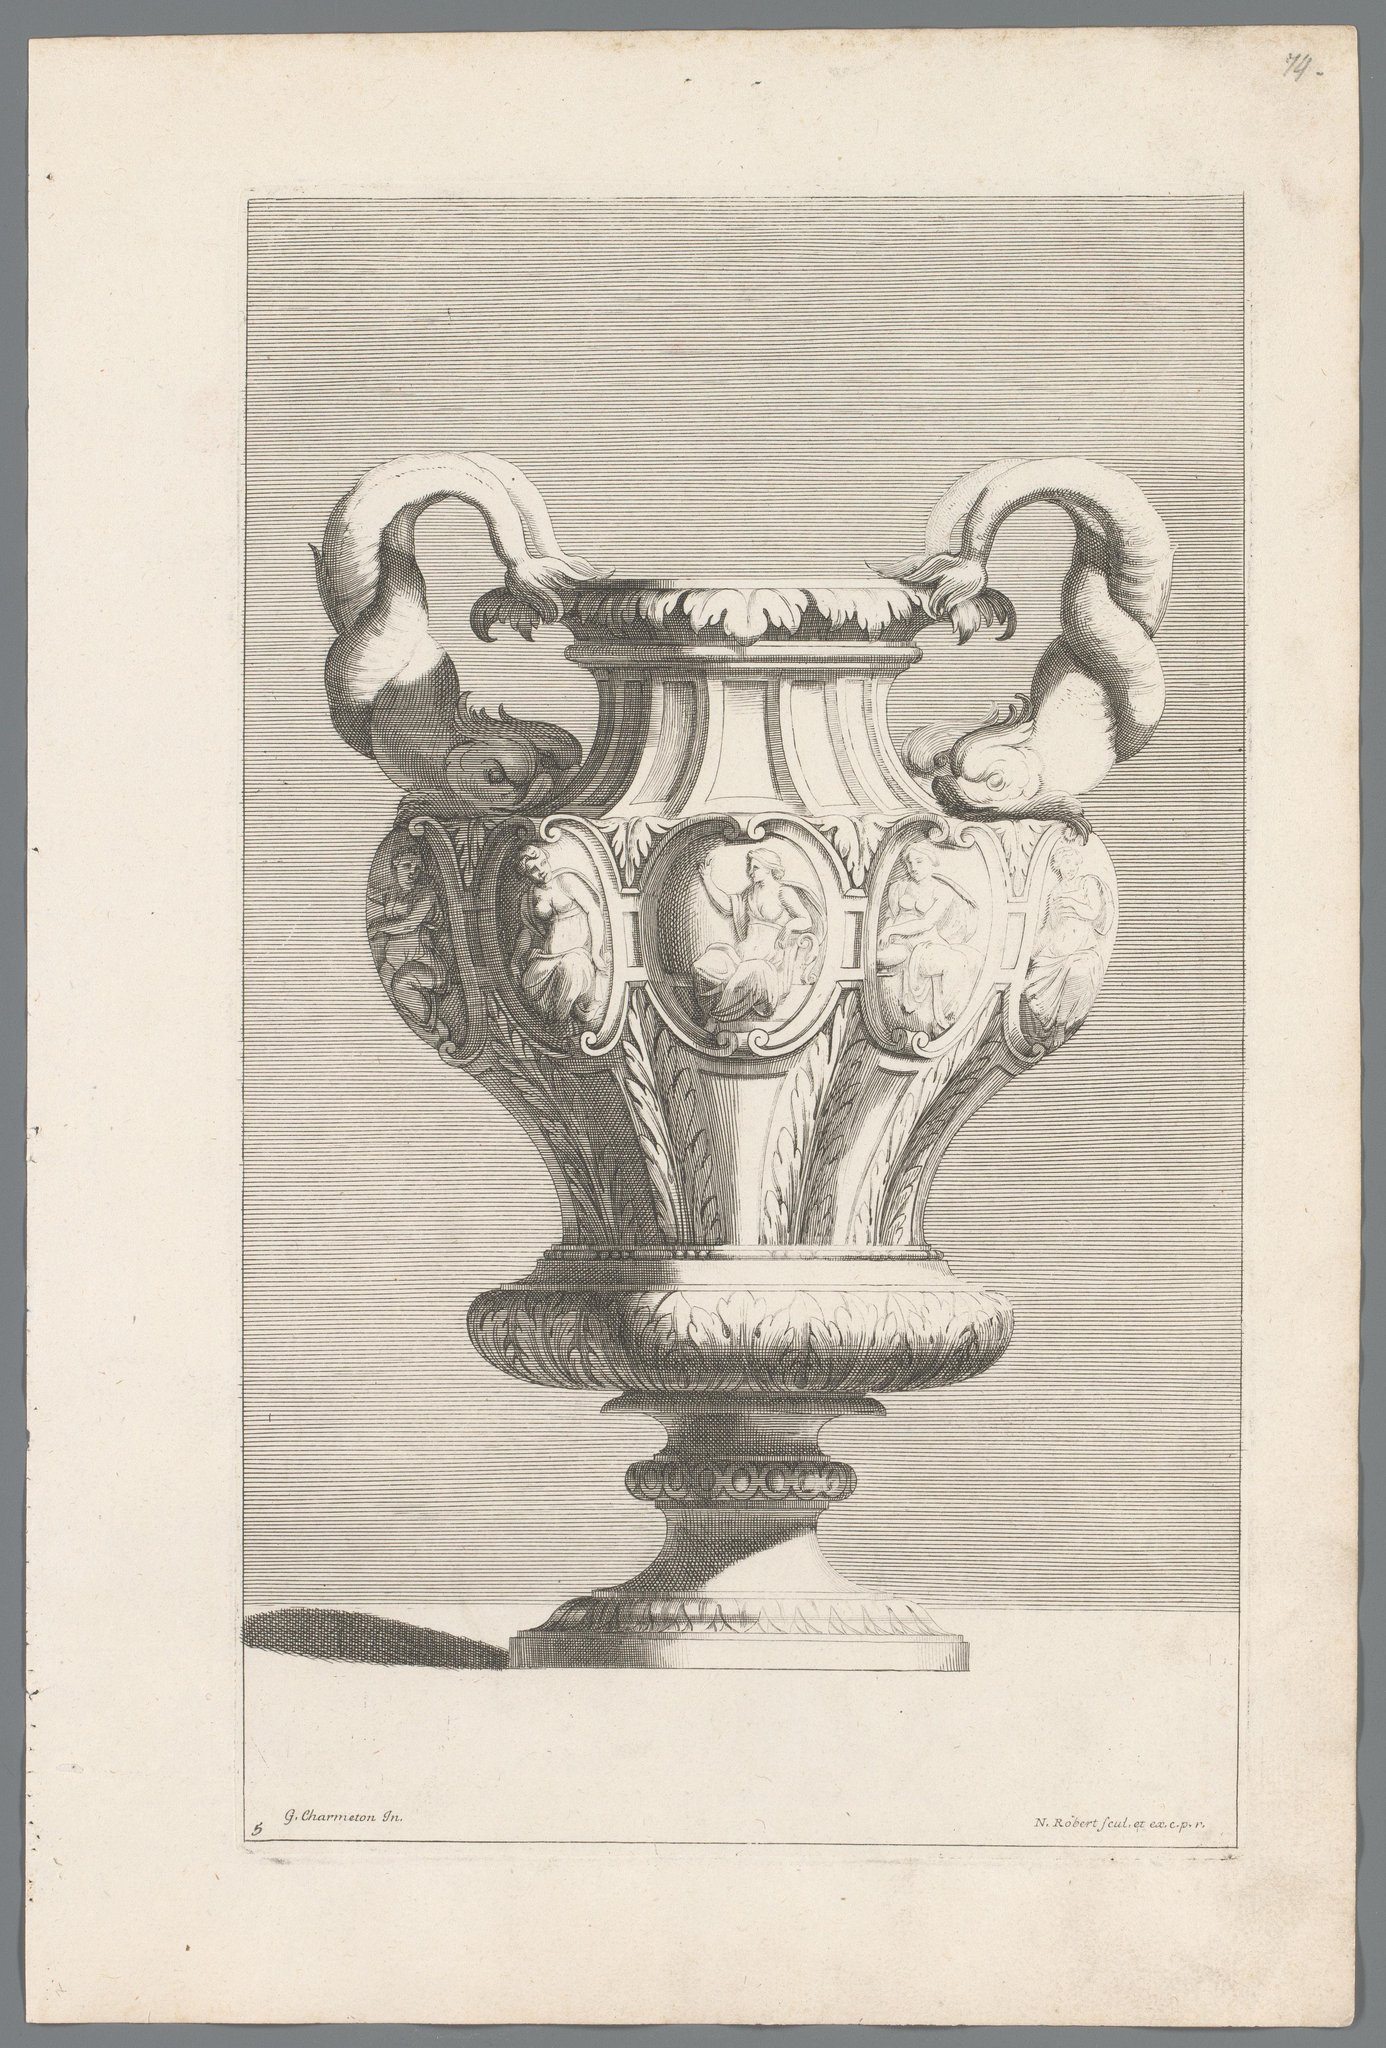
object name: ornament print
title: Plusieurs vaze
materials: paper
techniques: engraving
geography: paris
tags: vase ~ ornament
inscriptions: collector's mark: Lugt 2228, collector's mark: Lugt 2760